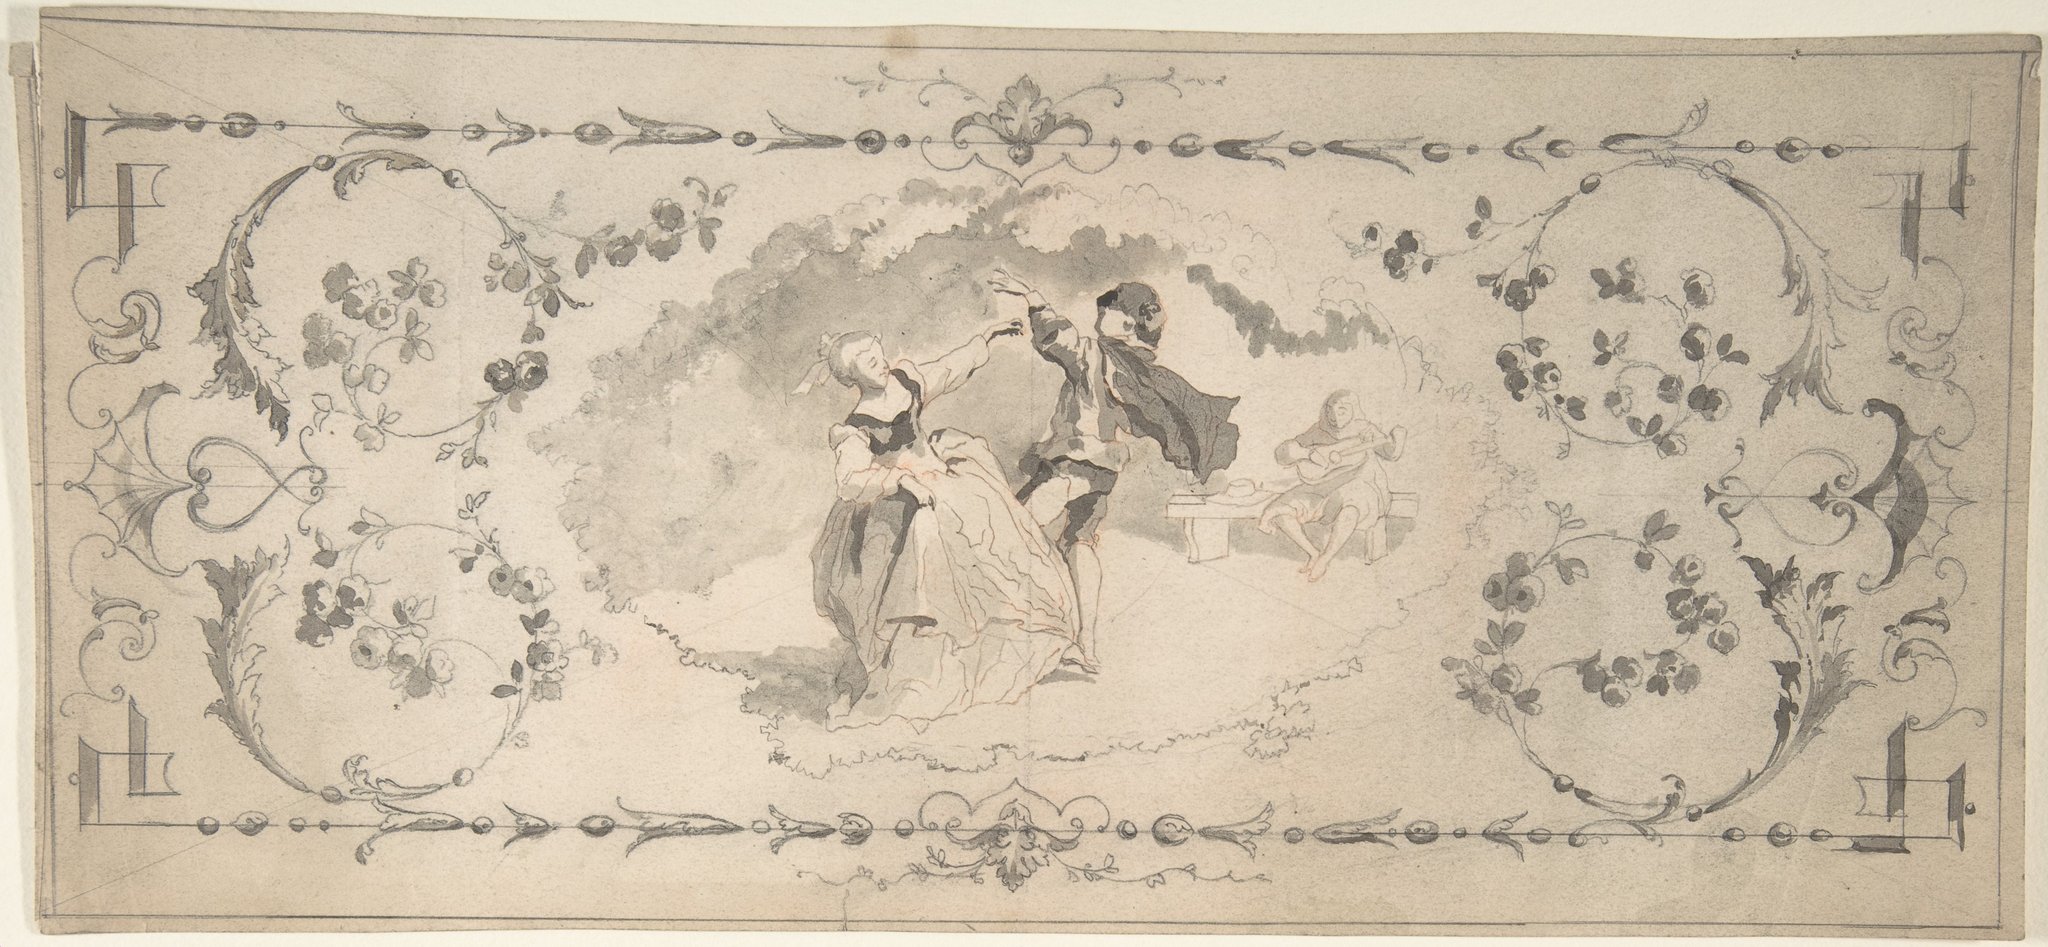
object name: drawing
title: Design with Dancers in a Cartouche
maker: anonymous, british, 19th century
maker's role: artist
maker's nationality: british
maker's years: 1800-1900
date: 1801-1900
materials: ink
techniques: brush, pen, wash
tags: cartouches,men,women,dancing,dancers